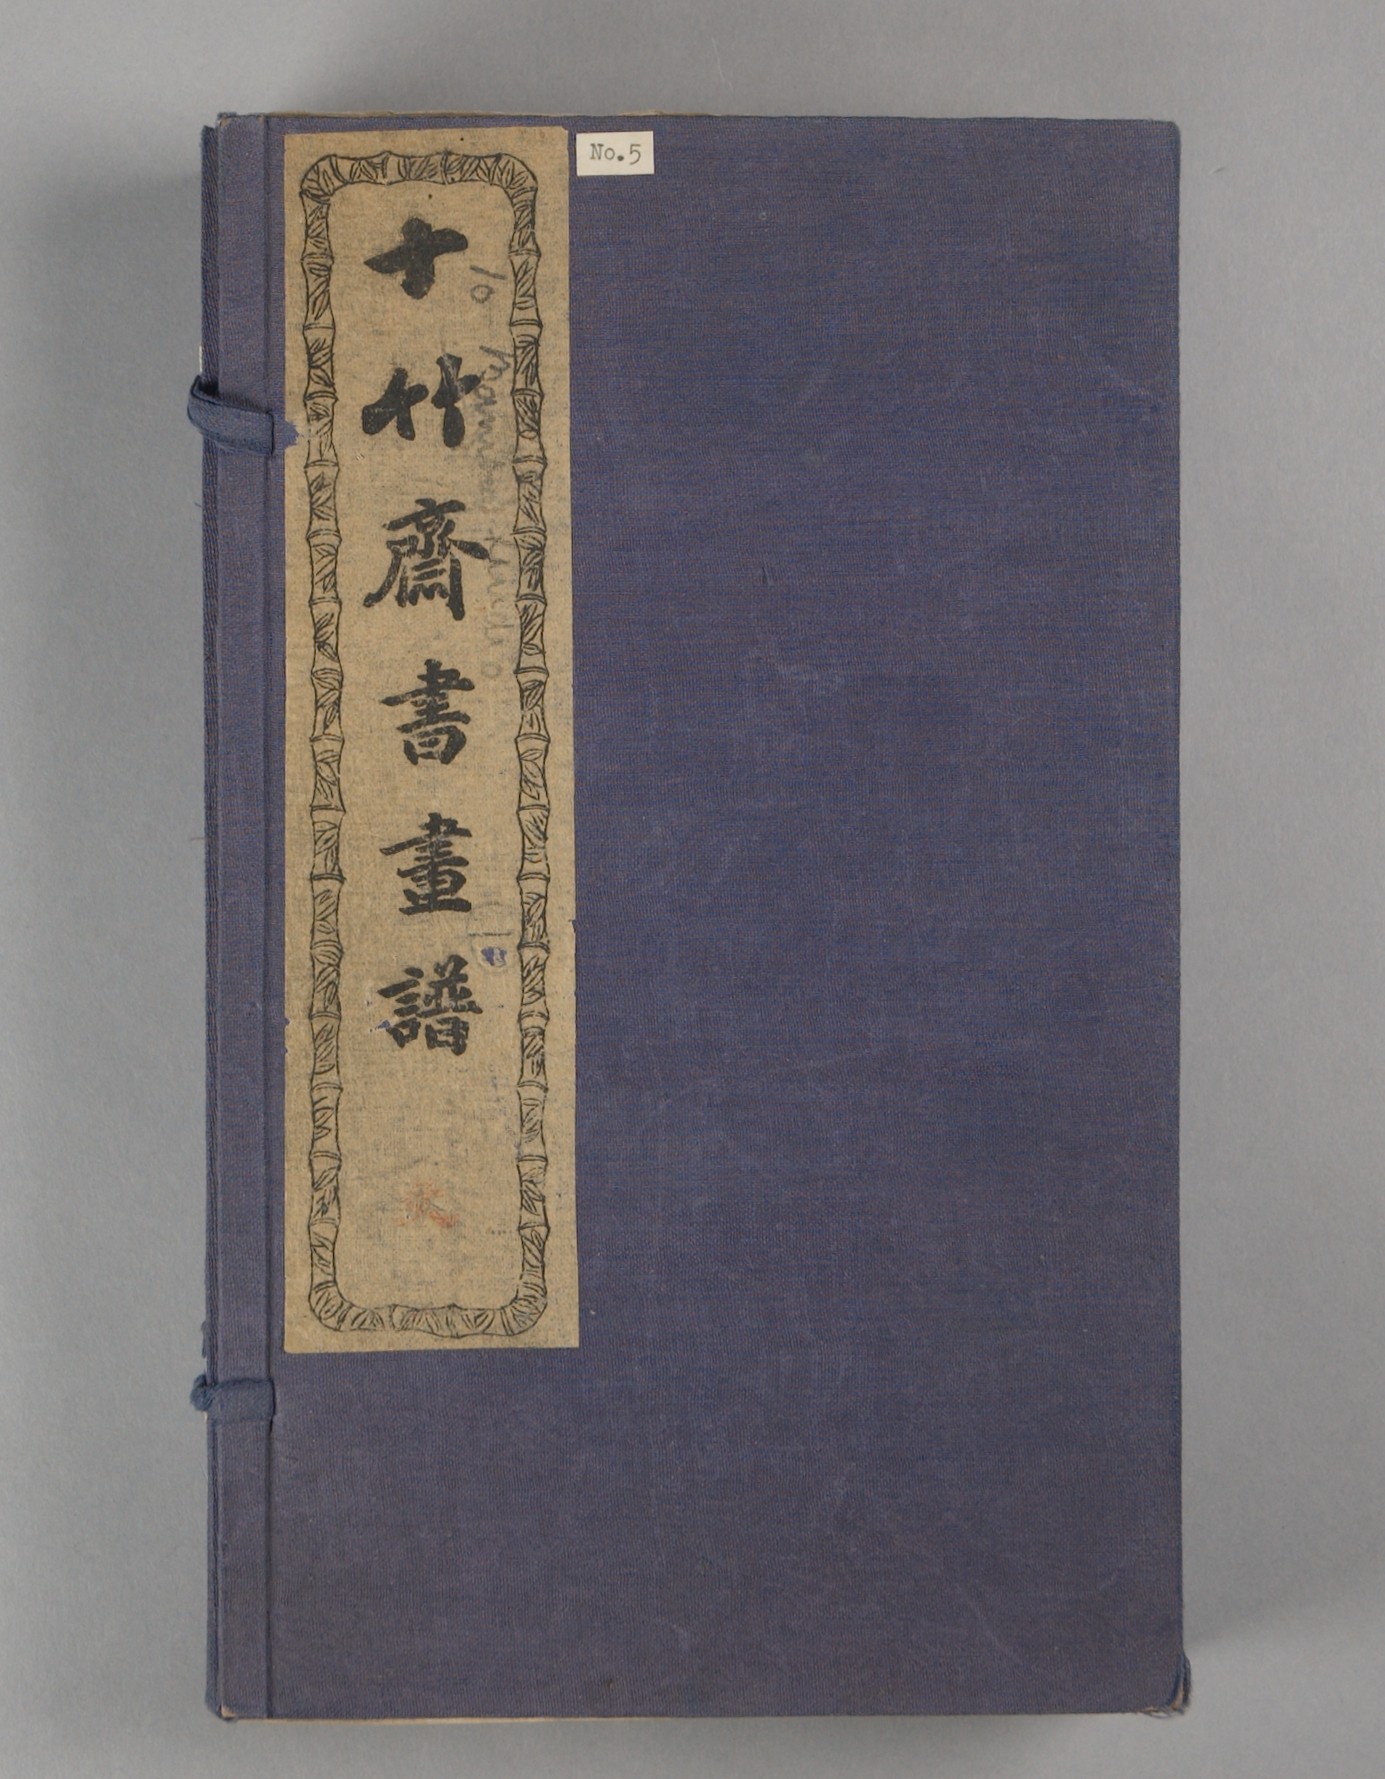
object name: illustrated book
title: Ten Bamboo Studio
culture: chinese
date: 1821-1850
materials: ink, paper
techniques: woodblock print